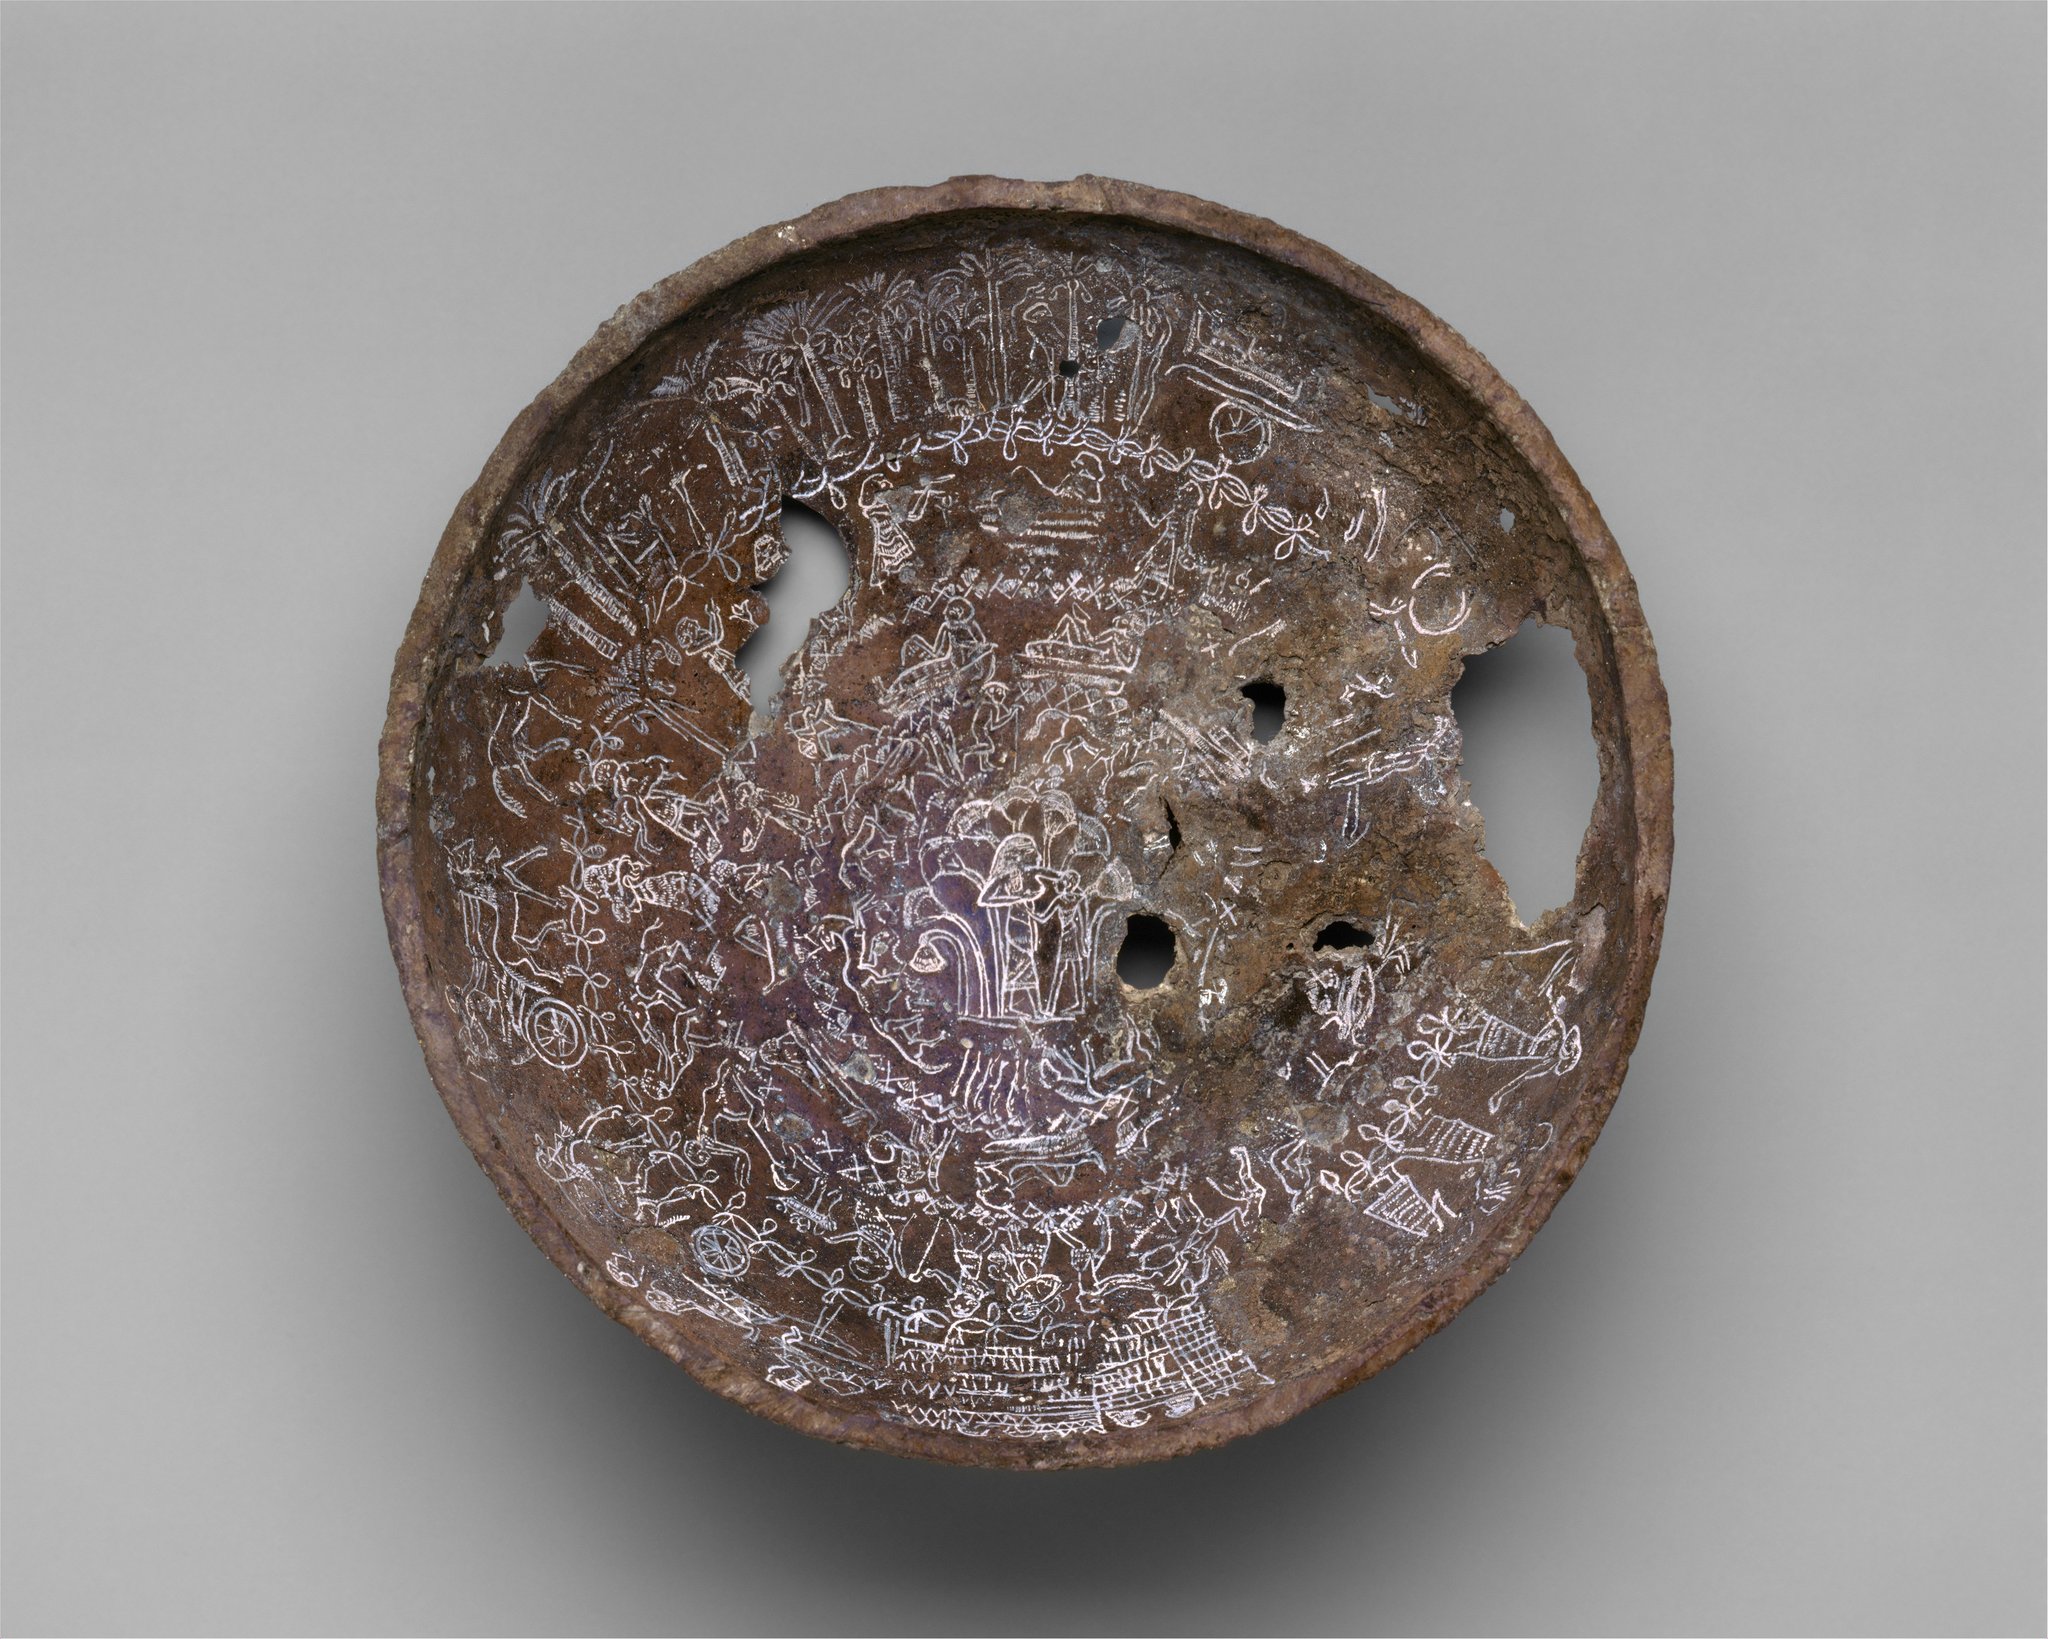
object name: bowl with medallion of isi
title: Silver bowl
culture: cypriot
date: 675-625 BCE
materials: silver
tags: animals,horus,isis